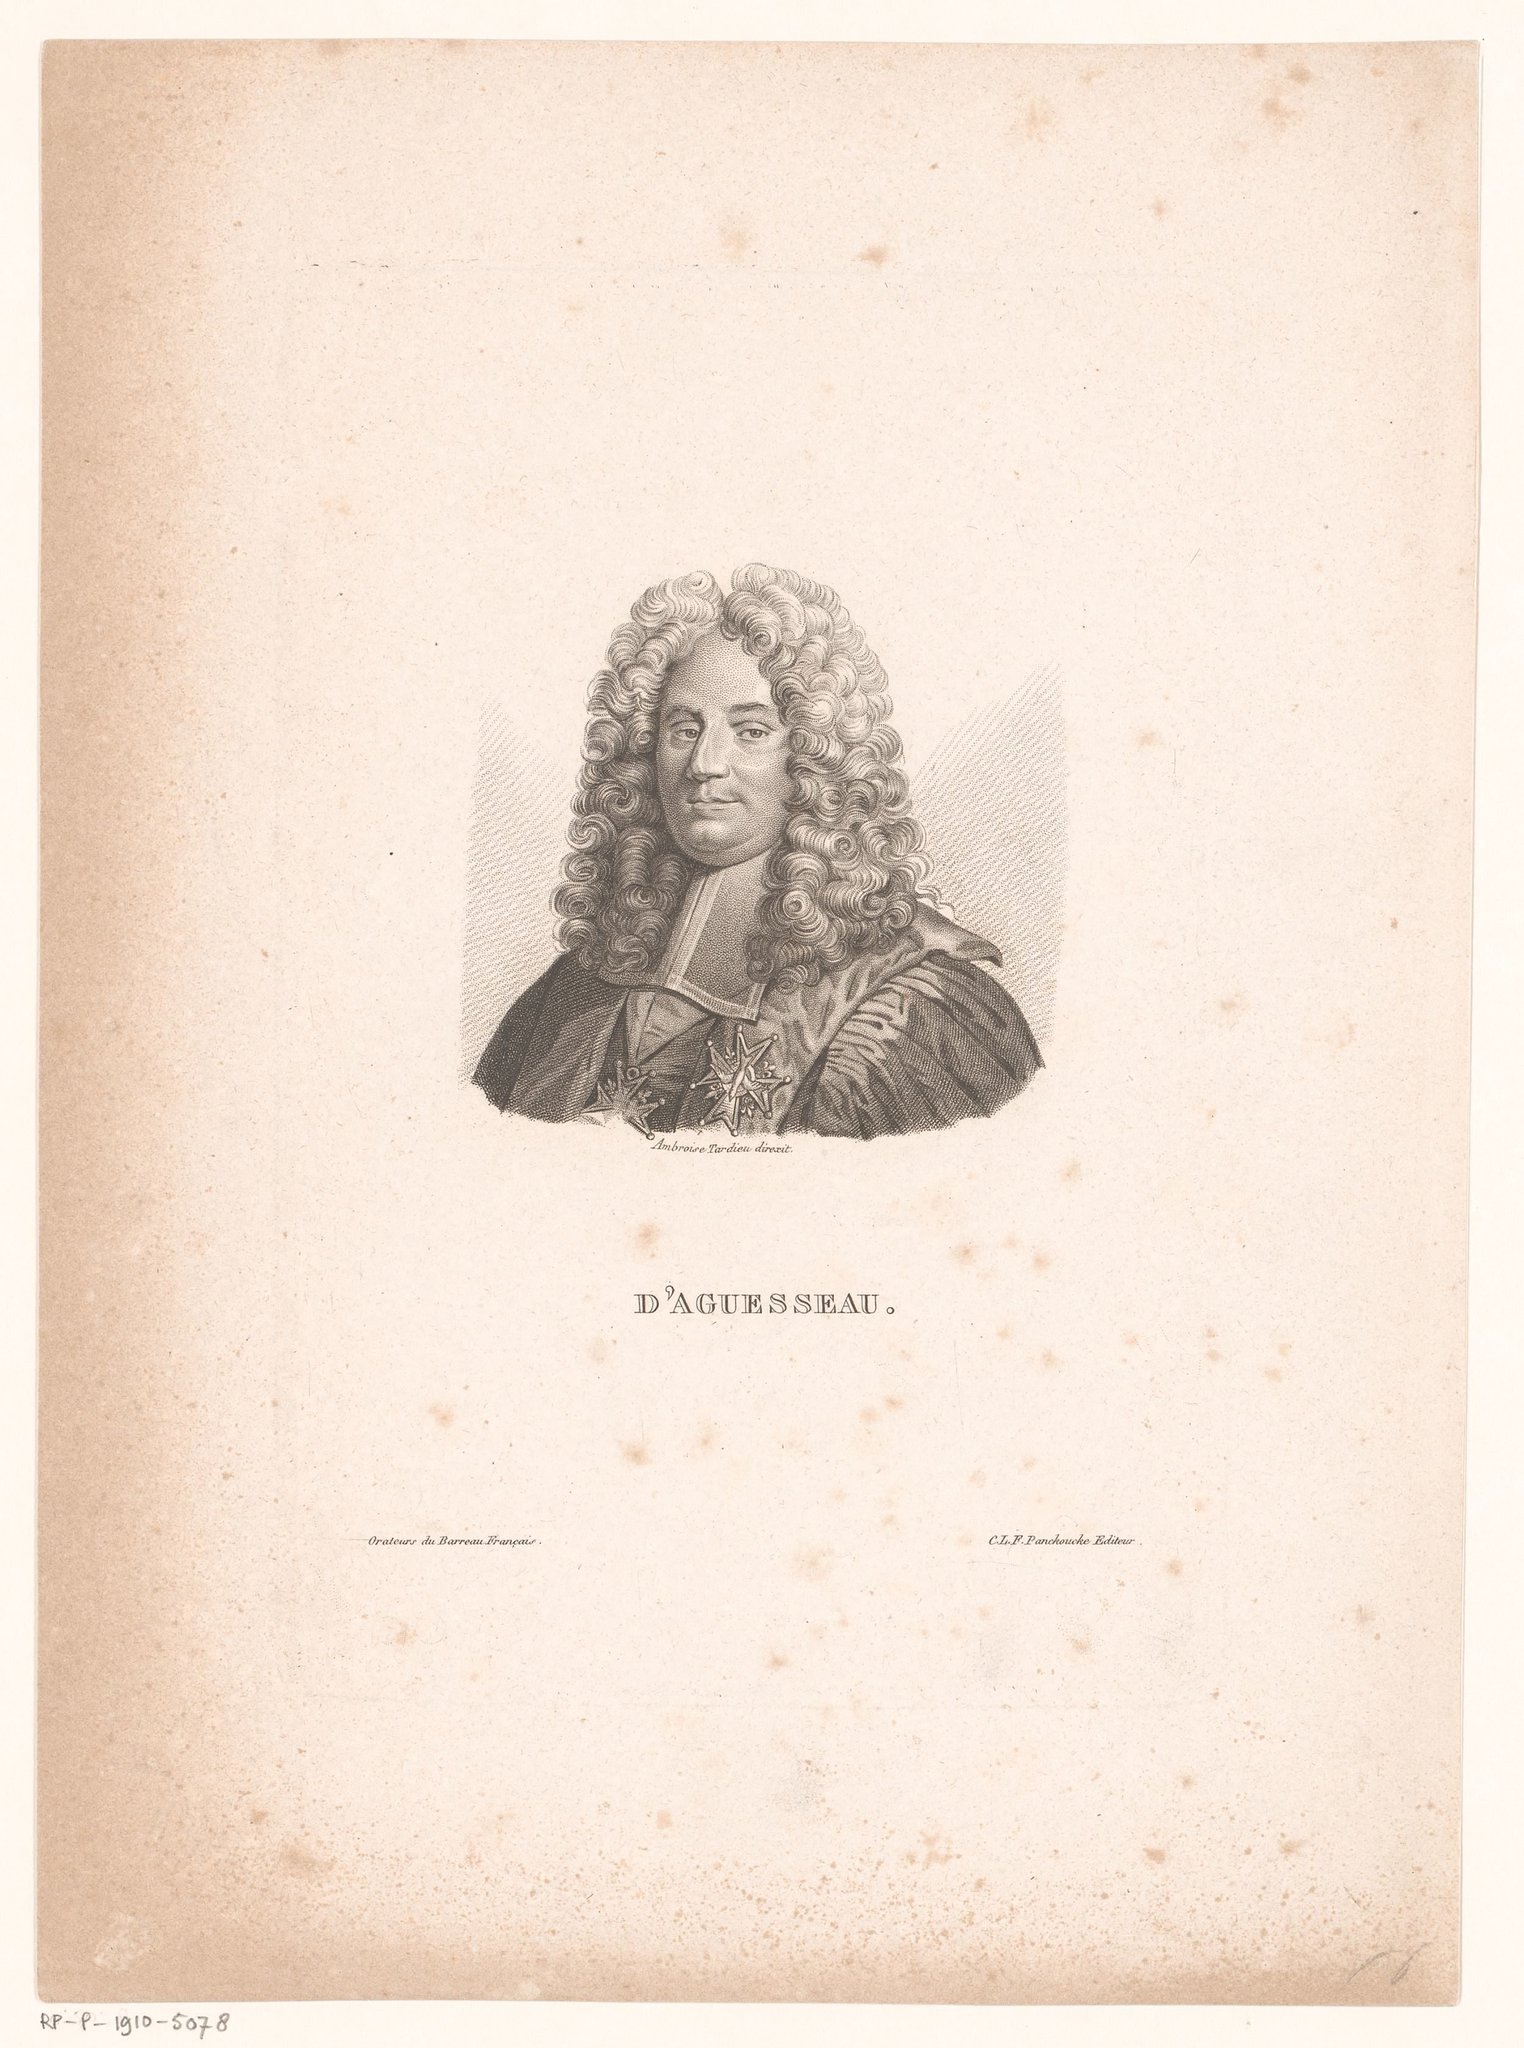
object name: print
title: Portret van Henri François d'Aguesseau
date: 1821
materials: paper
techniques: engraving, etching, roulette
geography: paris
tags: official; civil servant; functionary (in general), historical persons, decorations, honours (as symbols of the state, etc.)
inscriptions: collector's mark: Lugt 2228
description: Mogelijk prent uit: Barreau français. Collection des chefs-d'oeuvre de l'éloquence judiciaire en France. Parijs: Panckoucke, Charles Louis Fleury, ca. 1821.